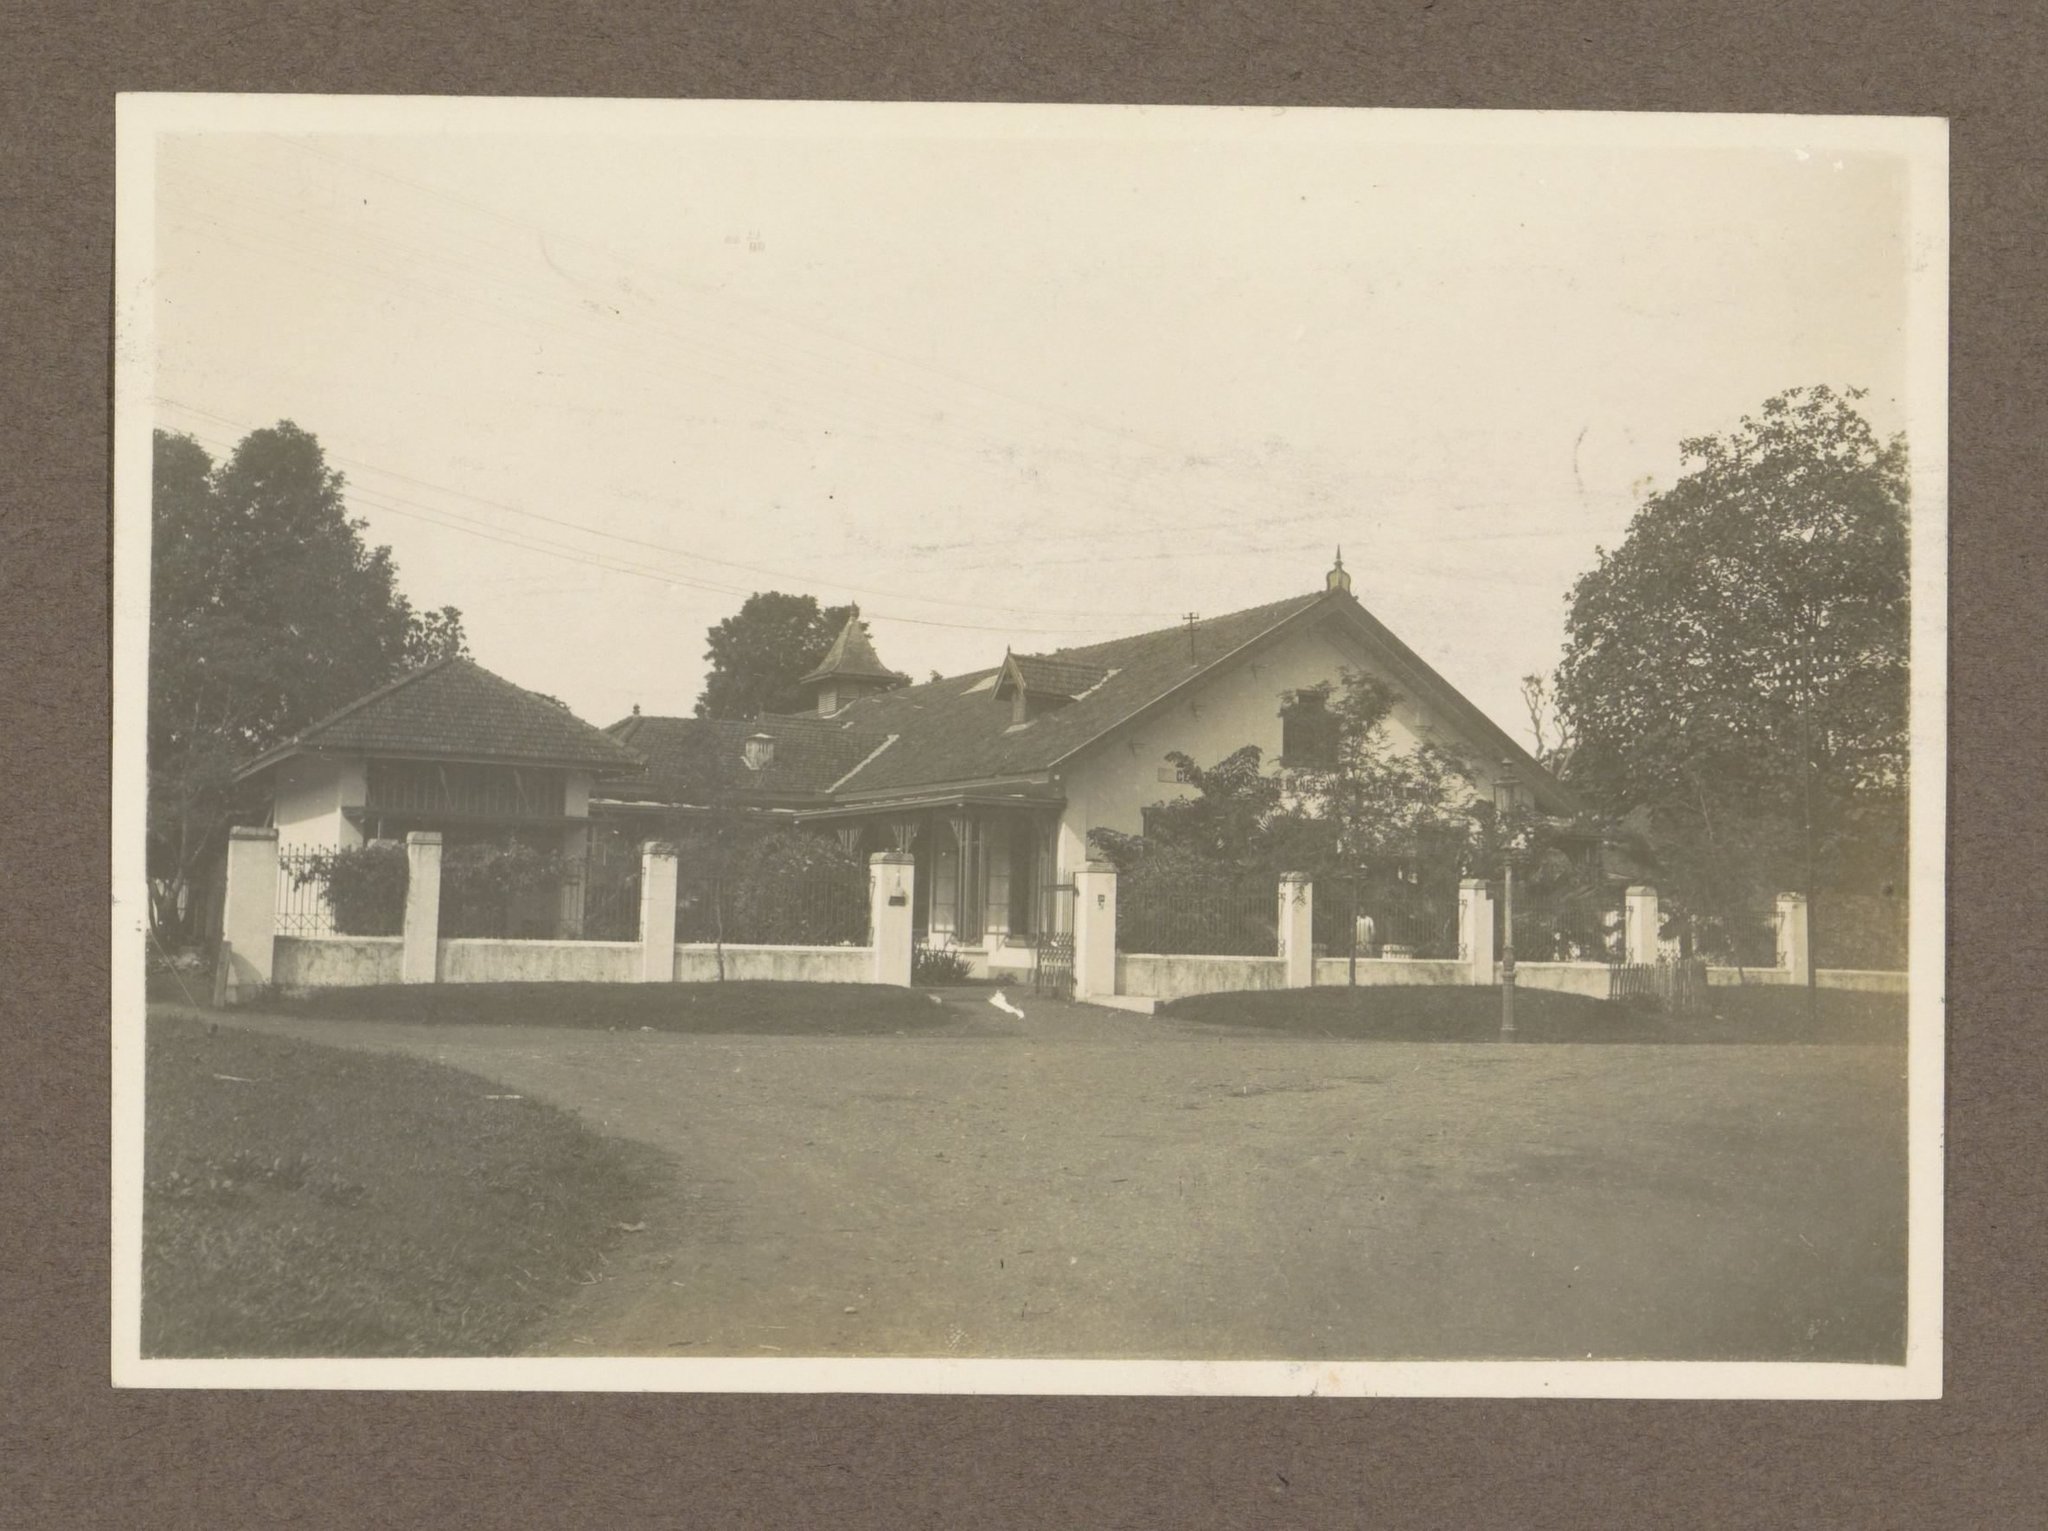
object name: photograph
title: Gezicht op een woning aan een weg in Nederlands-Indië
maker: klaas kleiterp (i)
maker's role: arts, officier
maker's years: 1892-1943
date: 1920-1930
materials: paper, photographic support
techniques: gelatin silver print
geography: dutch east indies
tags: rural housing, e.g. country-house, villa, cottage, dutch east indies, the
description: Onderdeel van Fotoalbum van de familie Kleiterp-Vermeulen met opnames van Nederlands-Indië.